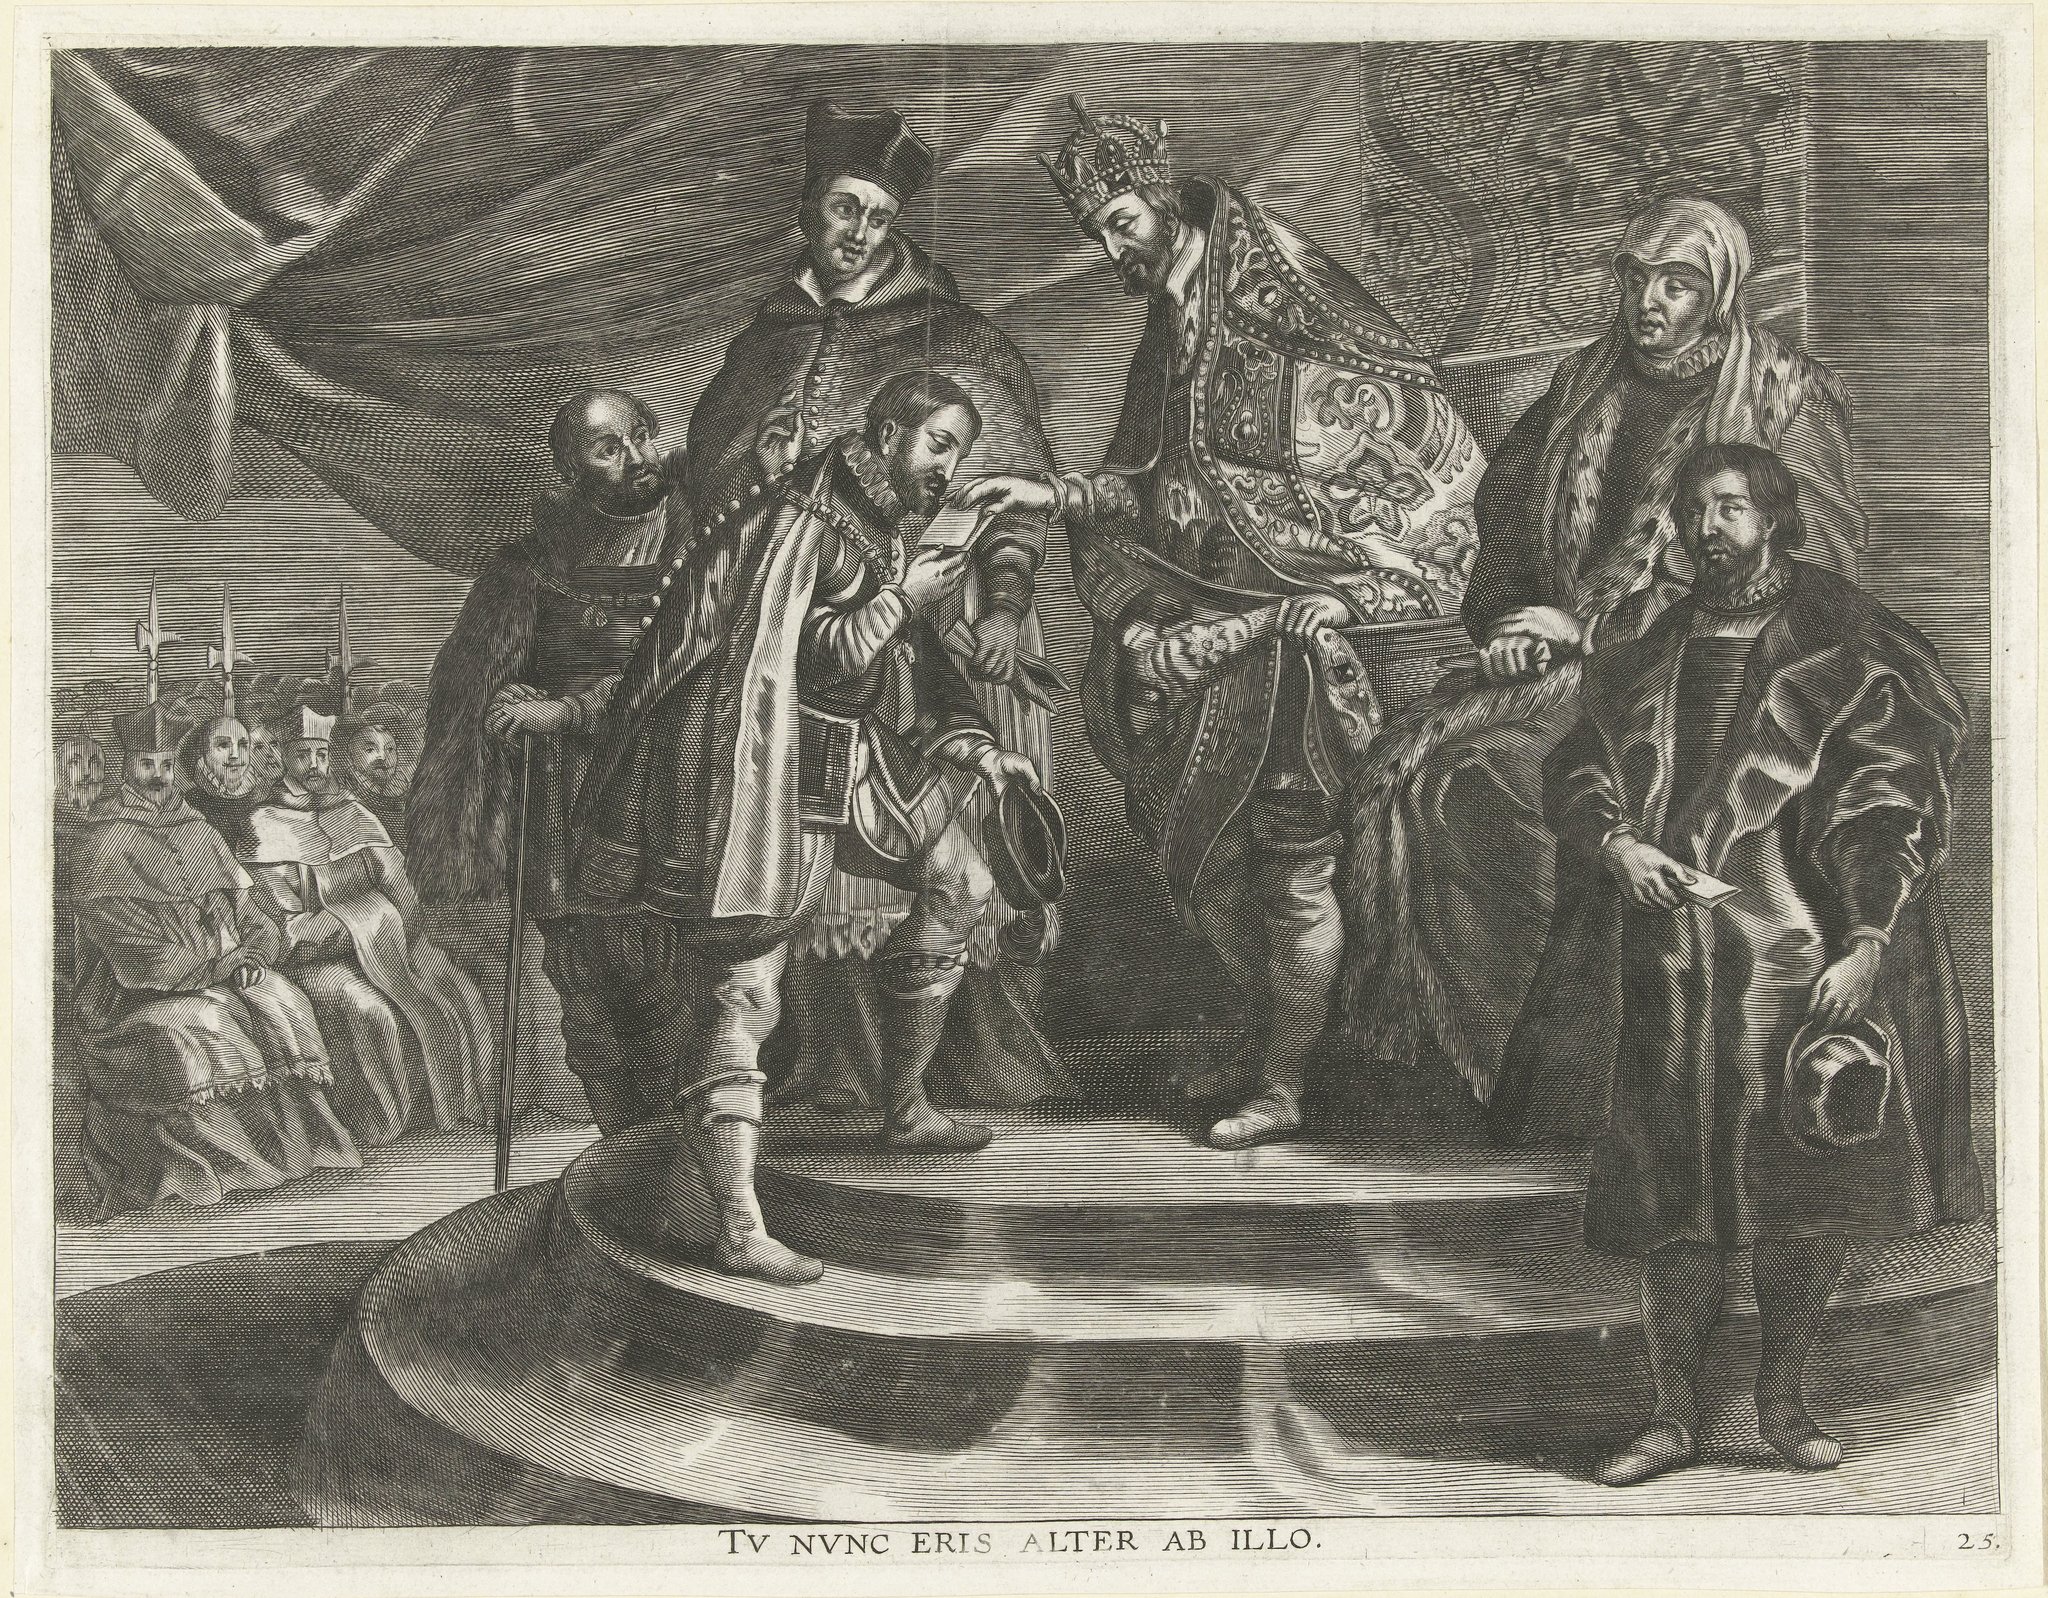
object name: print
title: Tv nvnc eris alter ab illo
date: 1635-1636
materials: paper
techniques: engraving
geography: southern netherlands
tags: philip ii of spain, antoine perrenot de granvelle, charles v (holy roman emperor and king of spain), maria van hongarije (landvoogdes der nederlanden), brussels, clergyman, landvoogd der zuidelijke nederlanden ferdinand van oostenrijk, triumphal arch, voluntary abdication (of a ruler), ghent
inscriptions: collector's mark: Lugt 240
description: Troonsafstand van keizer Karel V op 25 oktober 1555, waarin hij de regering van de Nederlanden overdraagt aan zijn zoon Filips. De keizer staande voor de troon, naast hem zit zijn zuster Maria van Hongarije. Verder aanwezig: Viglius van Aytta en kardinaal Granvelle. Filips II kust de hand van zijn vader. Voorstelling op een zijwand van de doorgang van de triomfpoort Arcus Caroli op de Vrijdagmarkt. Blad nr. 25 in een geheel van 42 platen die de uitgave van de beschrijving van de intocht van de Kardinaal Infant Ferdinand van Oostenrijk te Gent op 28 januari 1635 als de nieuwe landvoogd voor de Spaanse Nederlanden illustreren.